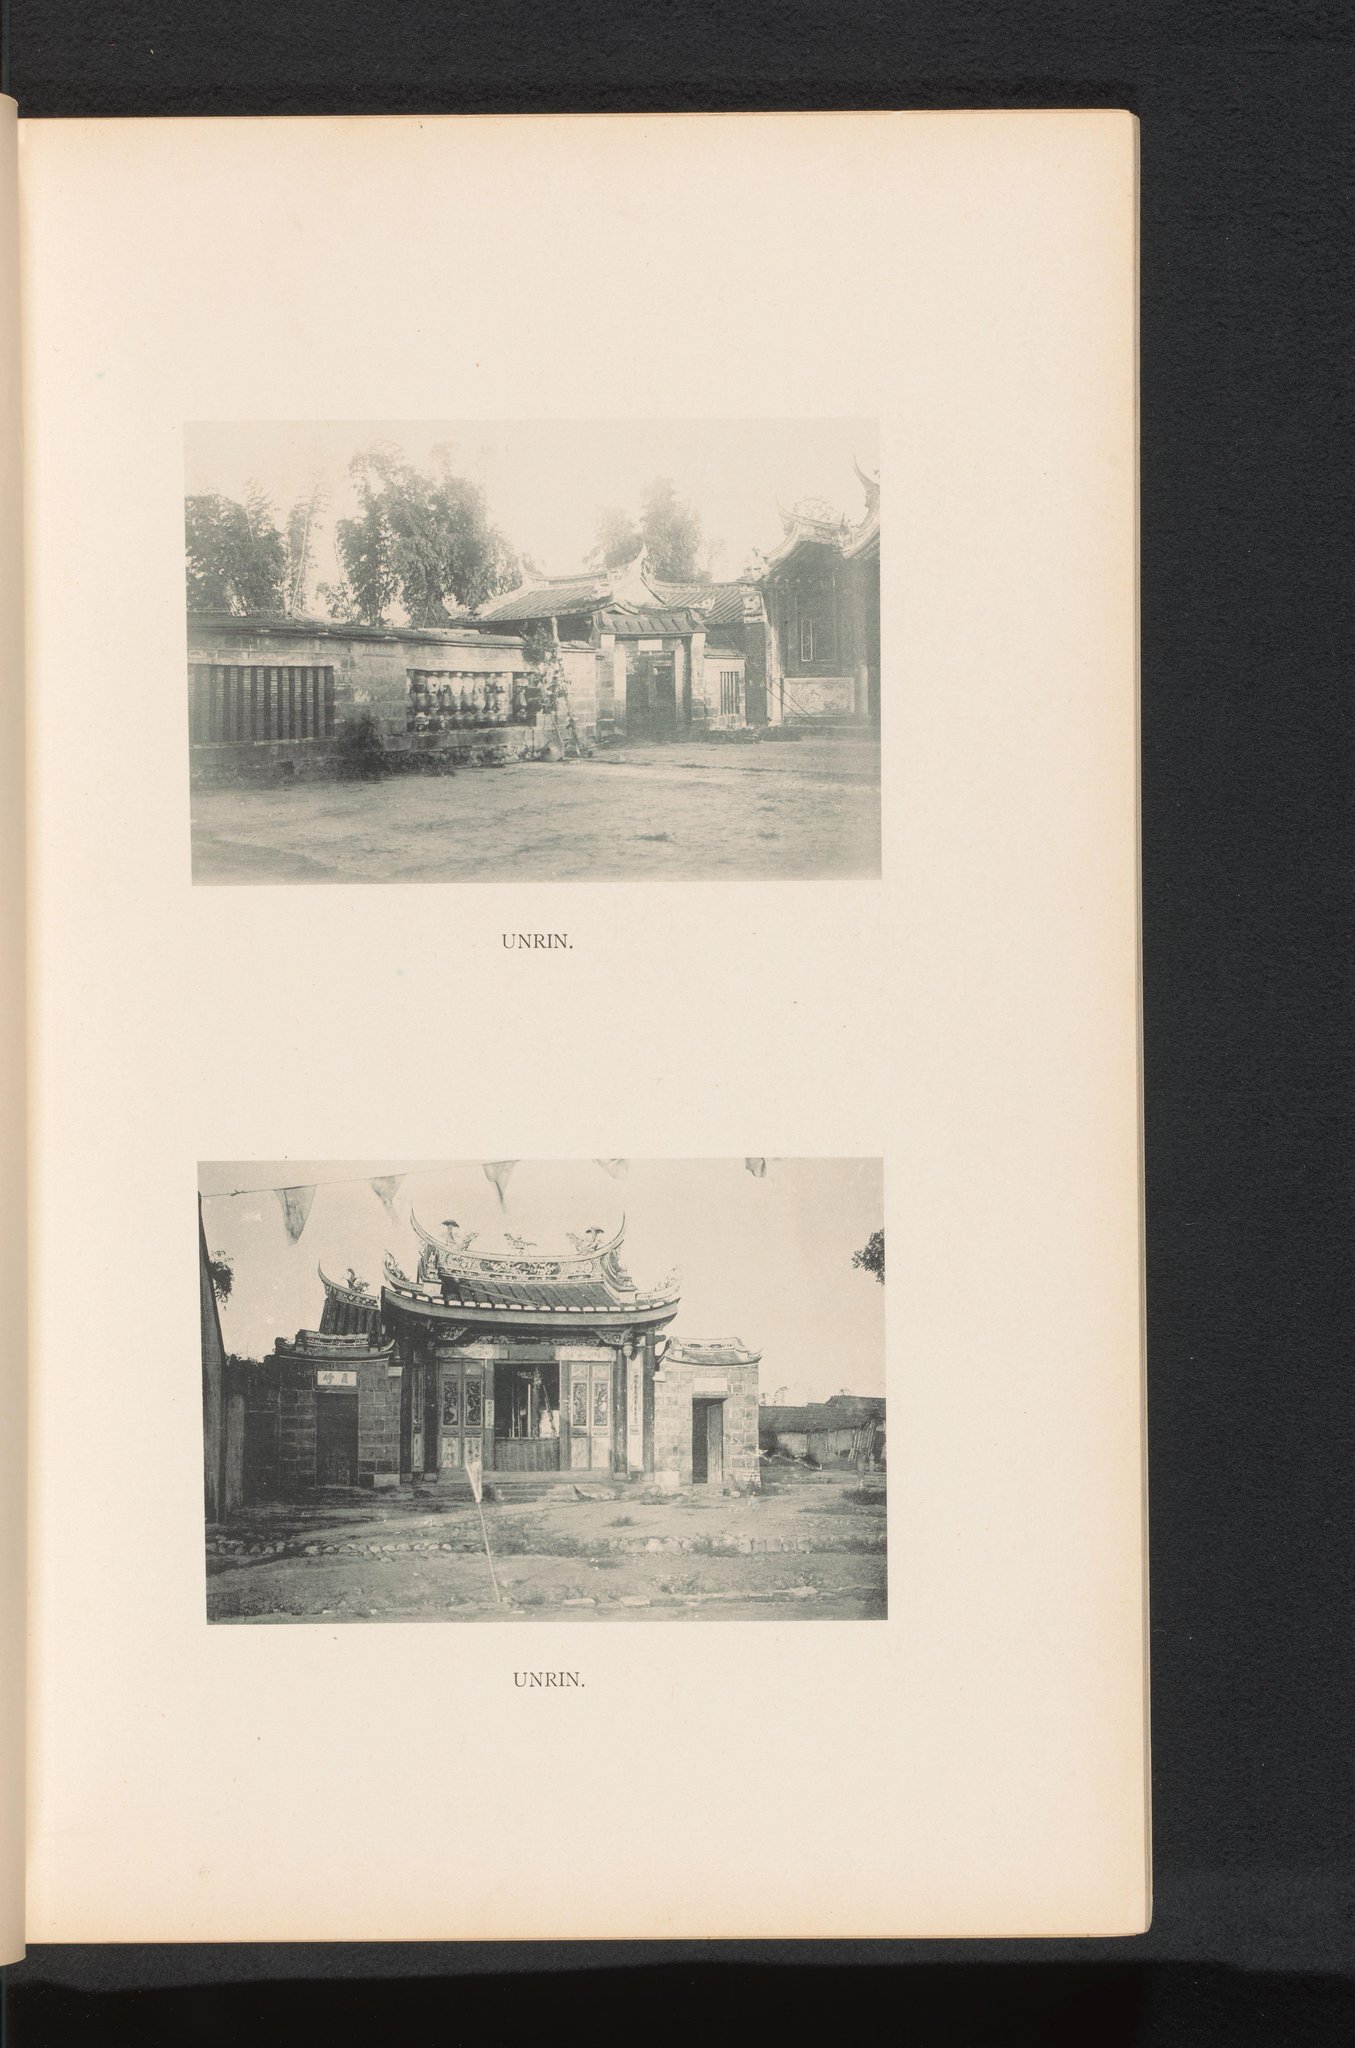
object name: page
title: Twee gezichten op een tempel te Yunlin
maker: Anonymous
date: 1891-1896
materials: paper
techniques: photograph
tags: temple, shrine ~ non-christian religions